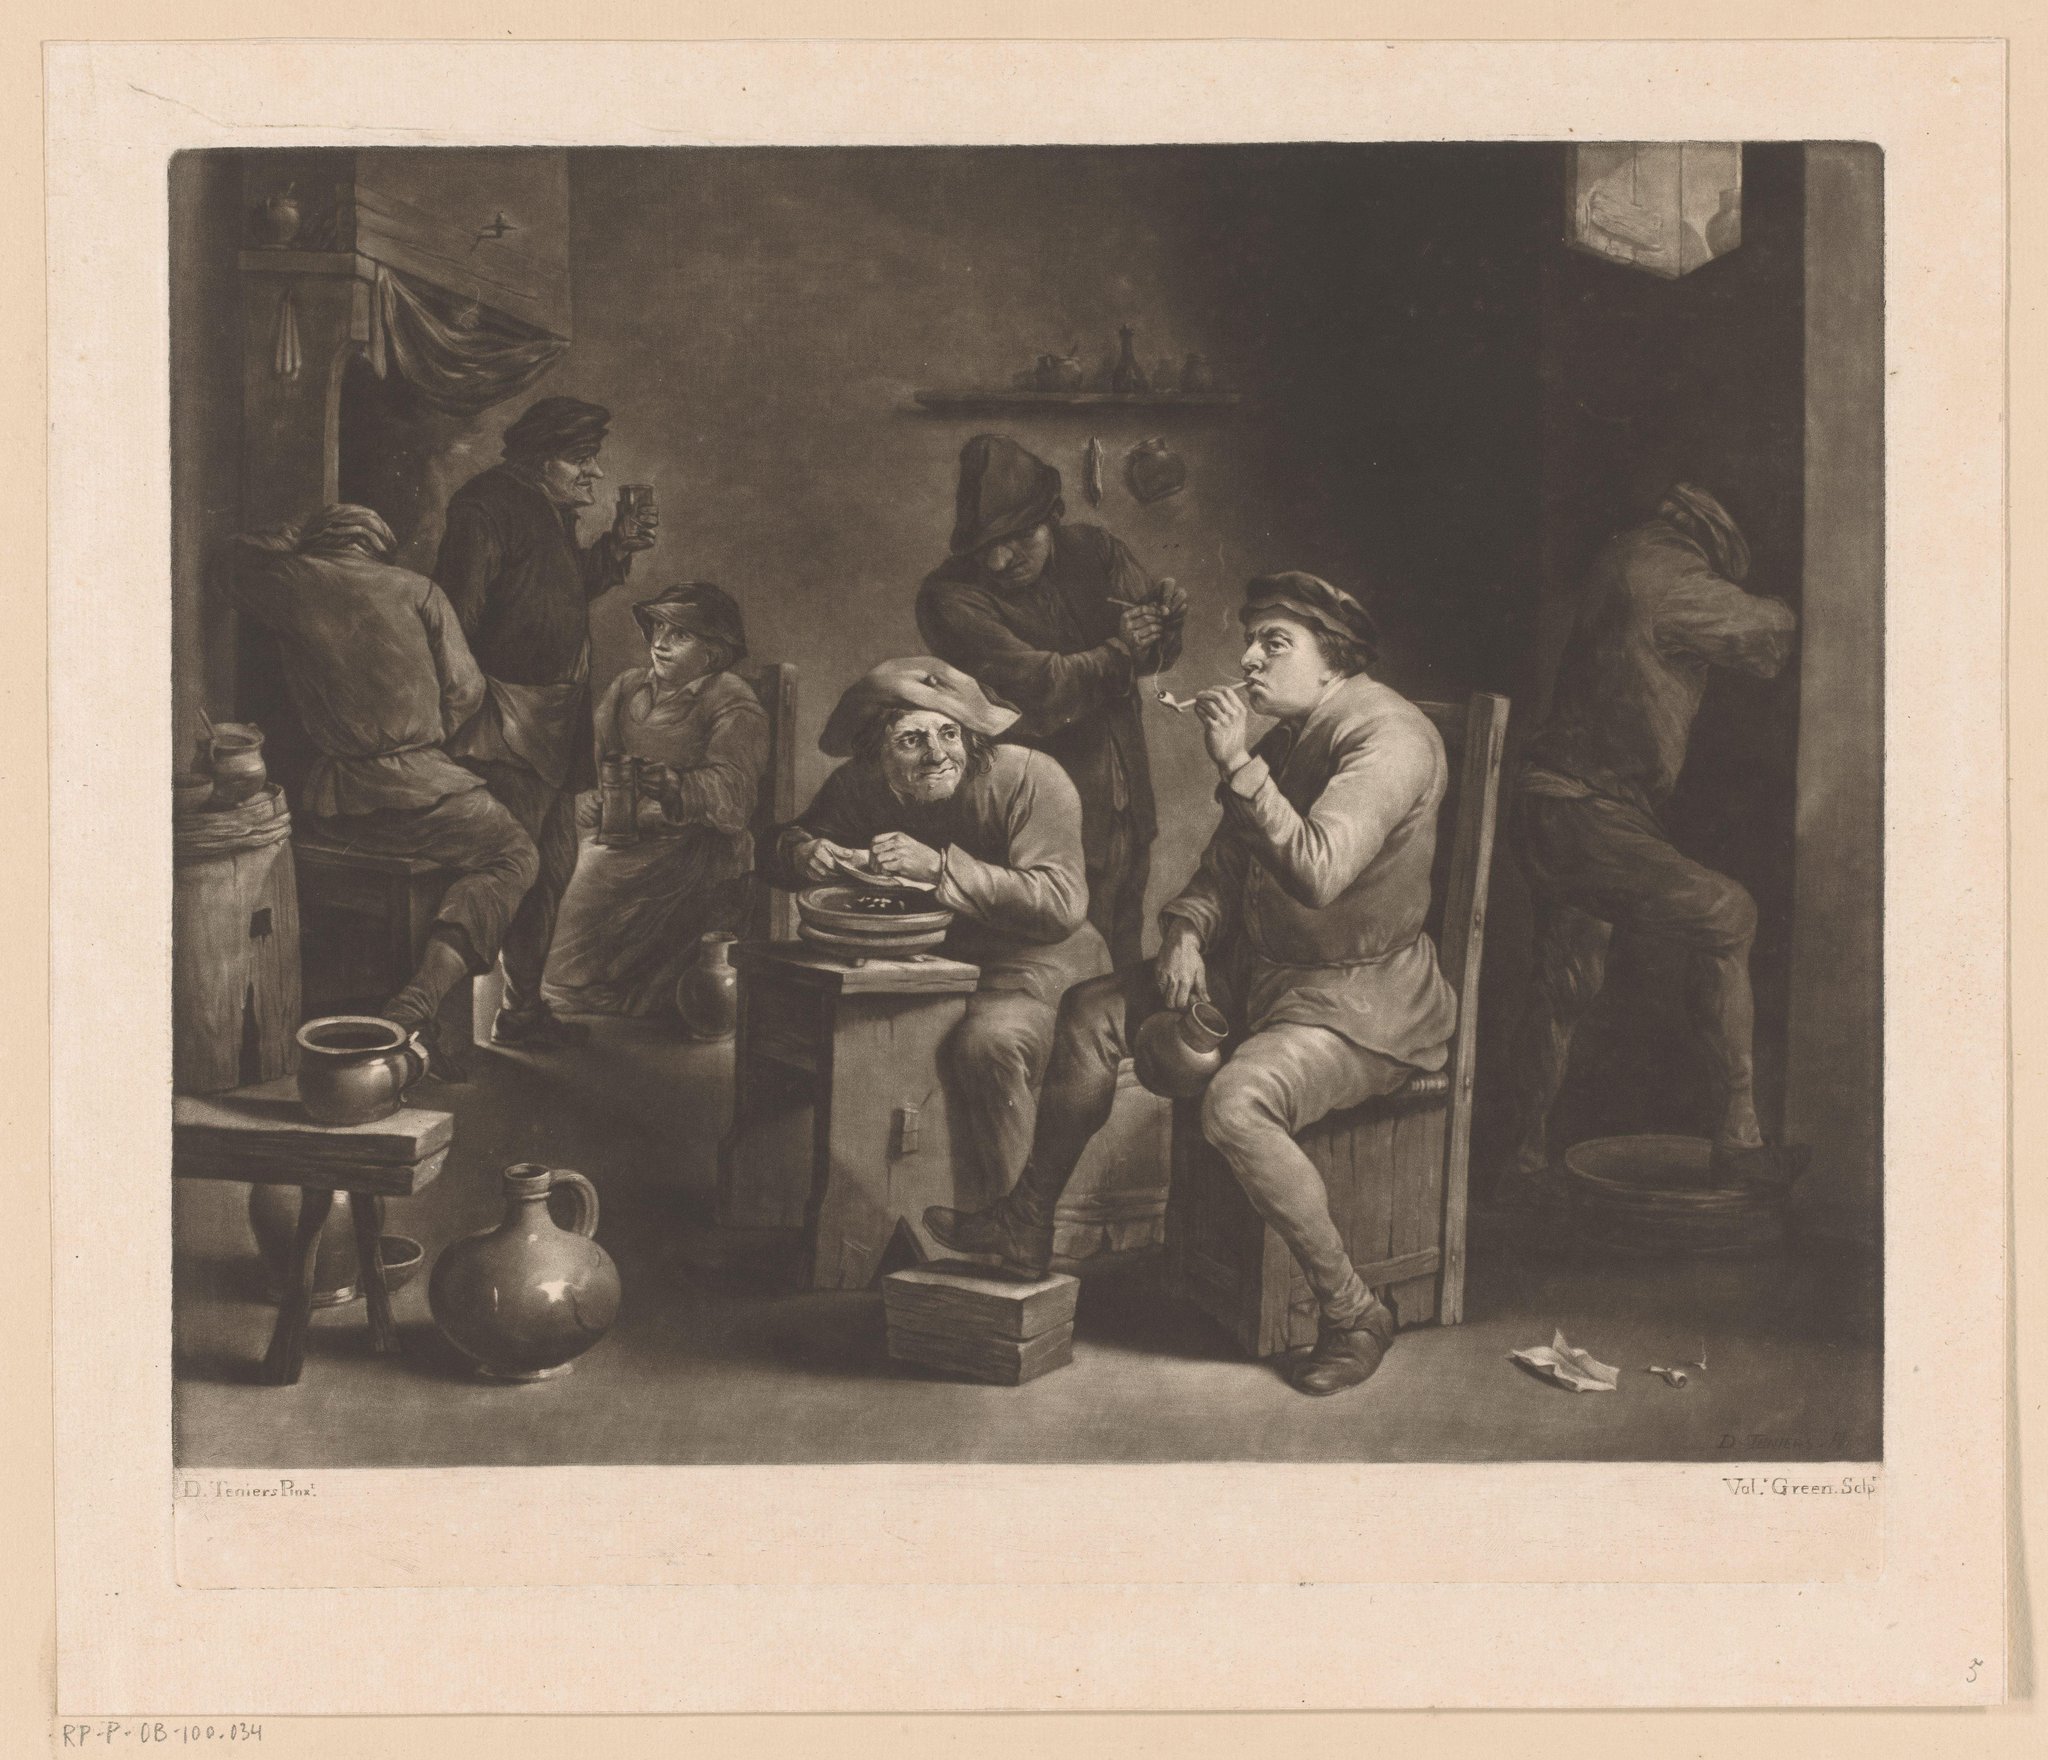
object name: print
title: Rokende en drinkende mannen in een herberg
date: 1778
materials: paper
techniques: mezzotint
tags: inn, coffee-house, public house, etc., pipe ~ tobacco, drunkenness, alcoholic drinks, hotel, hostelry, inn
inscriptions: collector's mark: Lugt 240